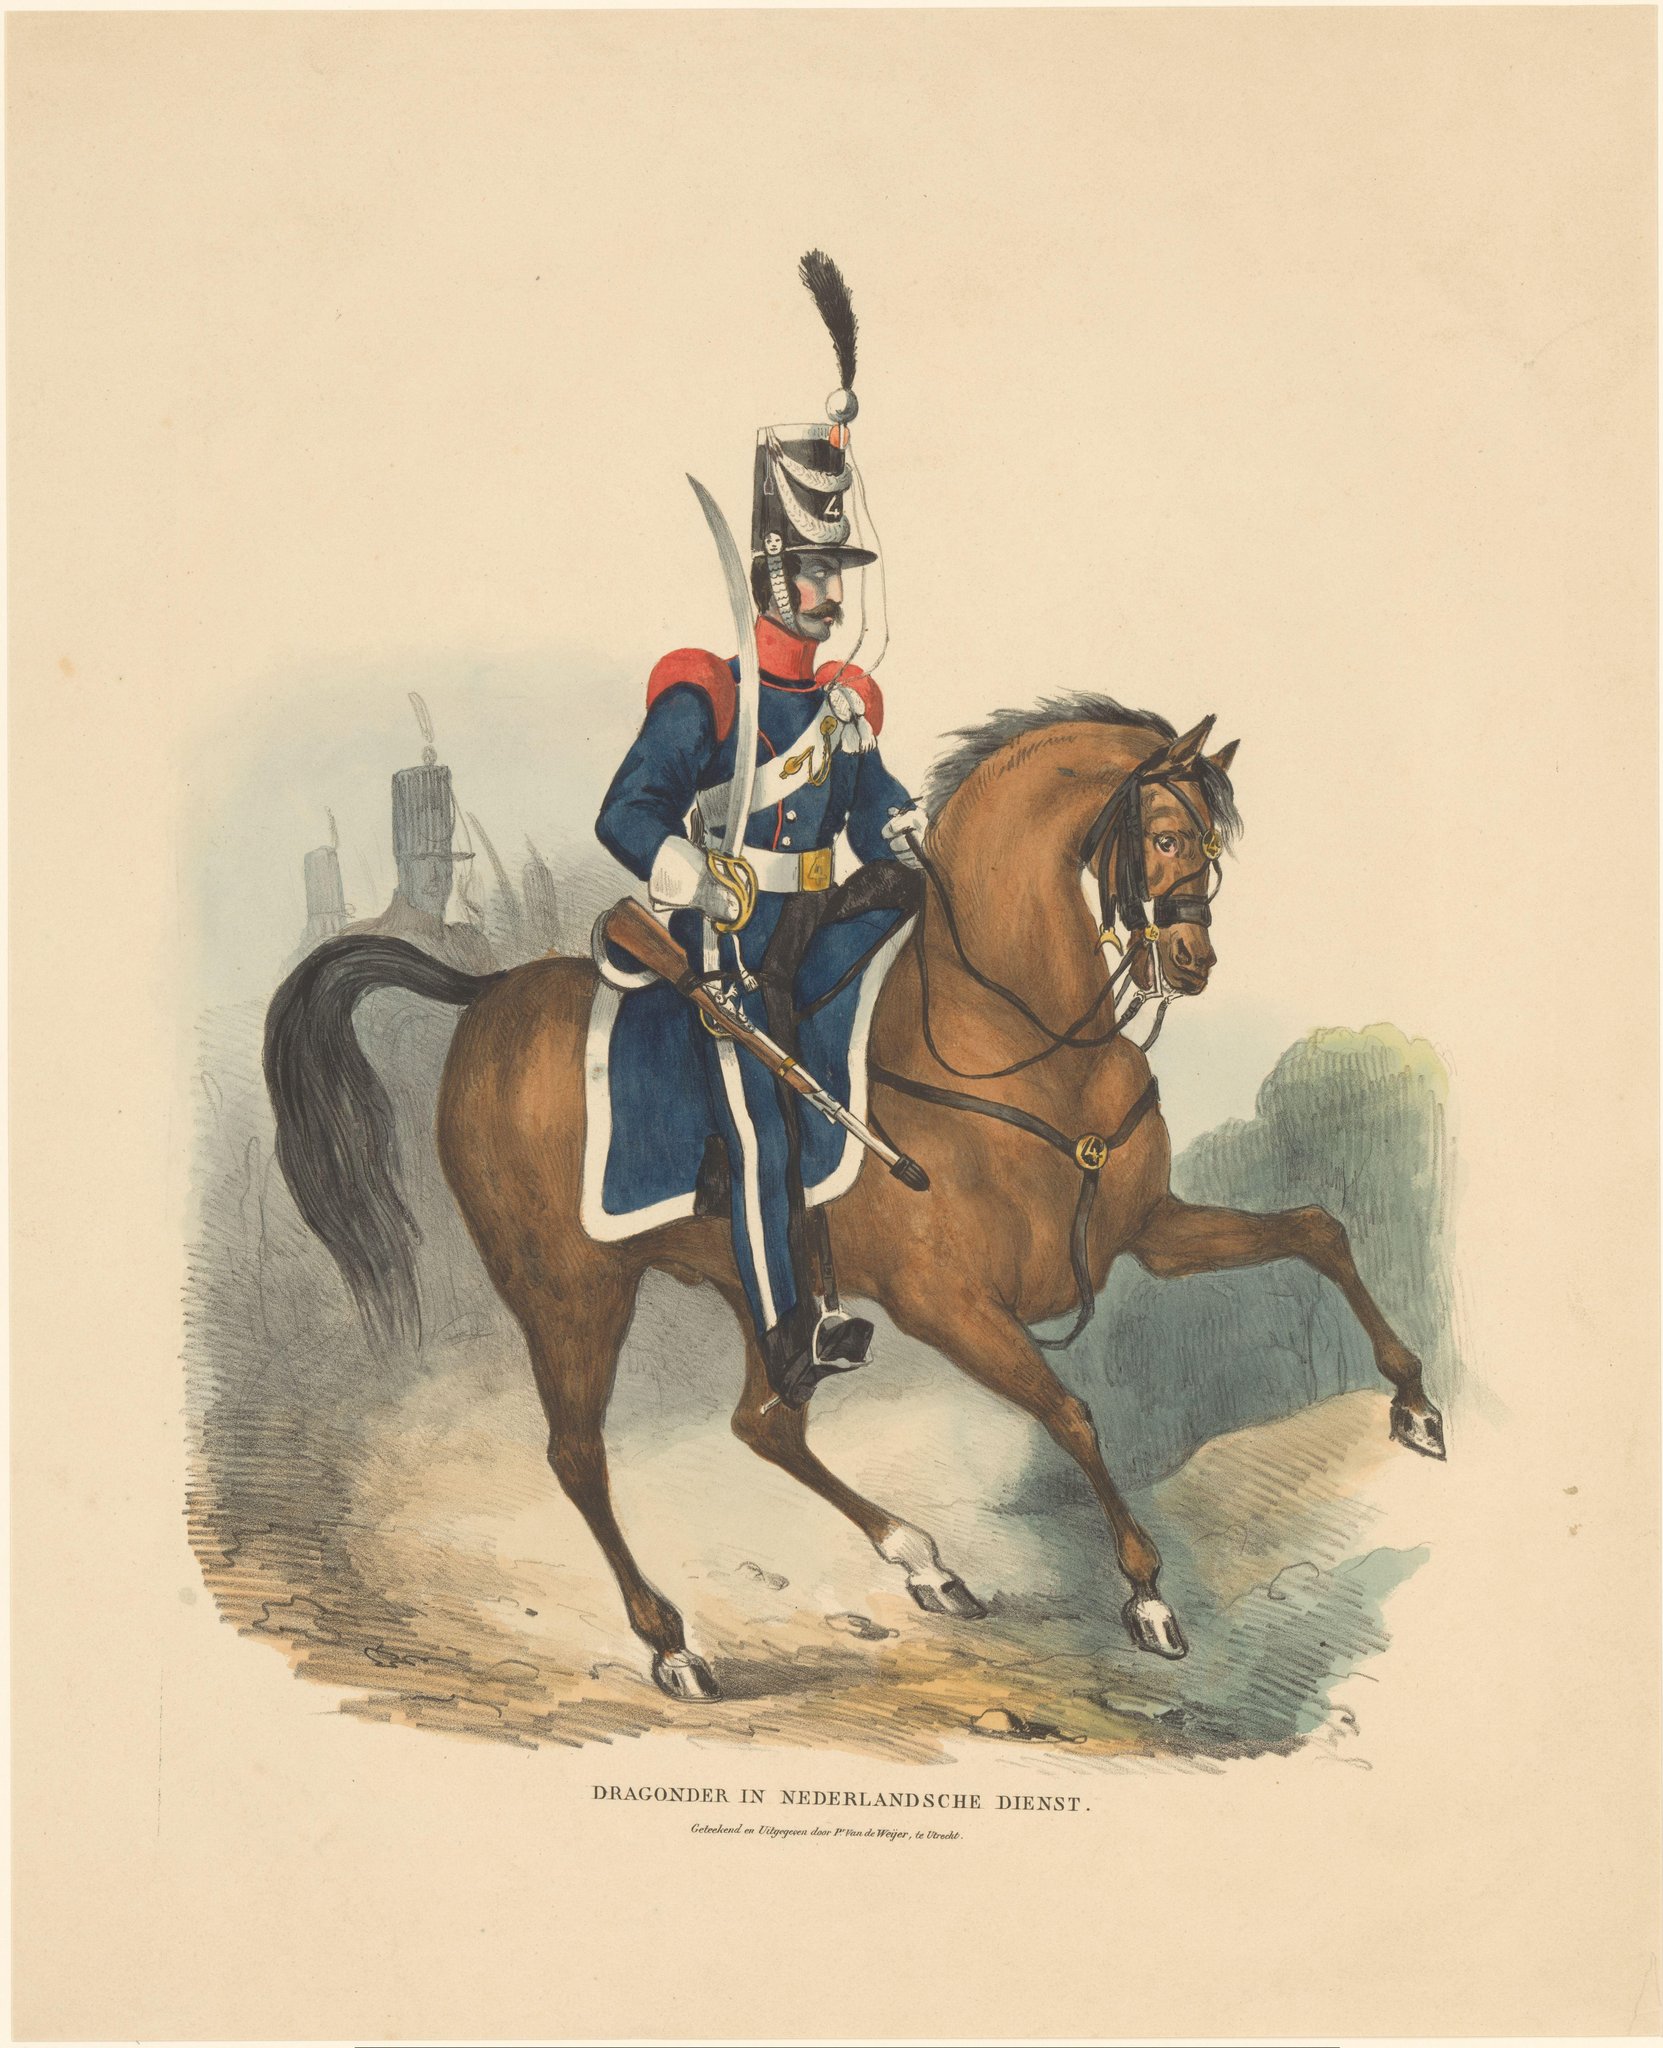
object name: print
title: Soldaat te paard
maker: pieter wilhelmus van de weijer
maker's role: print maker, printer, publisher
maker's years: 1816-1880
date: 1842-1880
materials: paper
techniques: hand coloring, lithograph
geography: utrecht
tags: private soldier (+ cavalry, horsemen), hacking and thrusting weapons (with name), firearms: rifle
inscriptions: collector's mark: Lugt 2228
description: De soldaat heeft een sabel in zijn rechterhand en een geweer aan zijn broek. Achter hem meer soldaten.